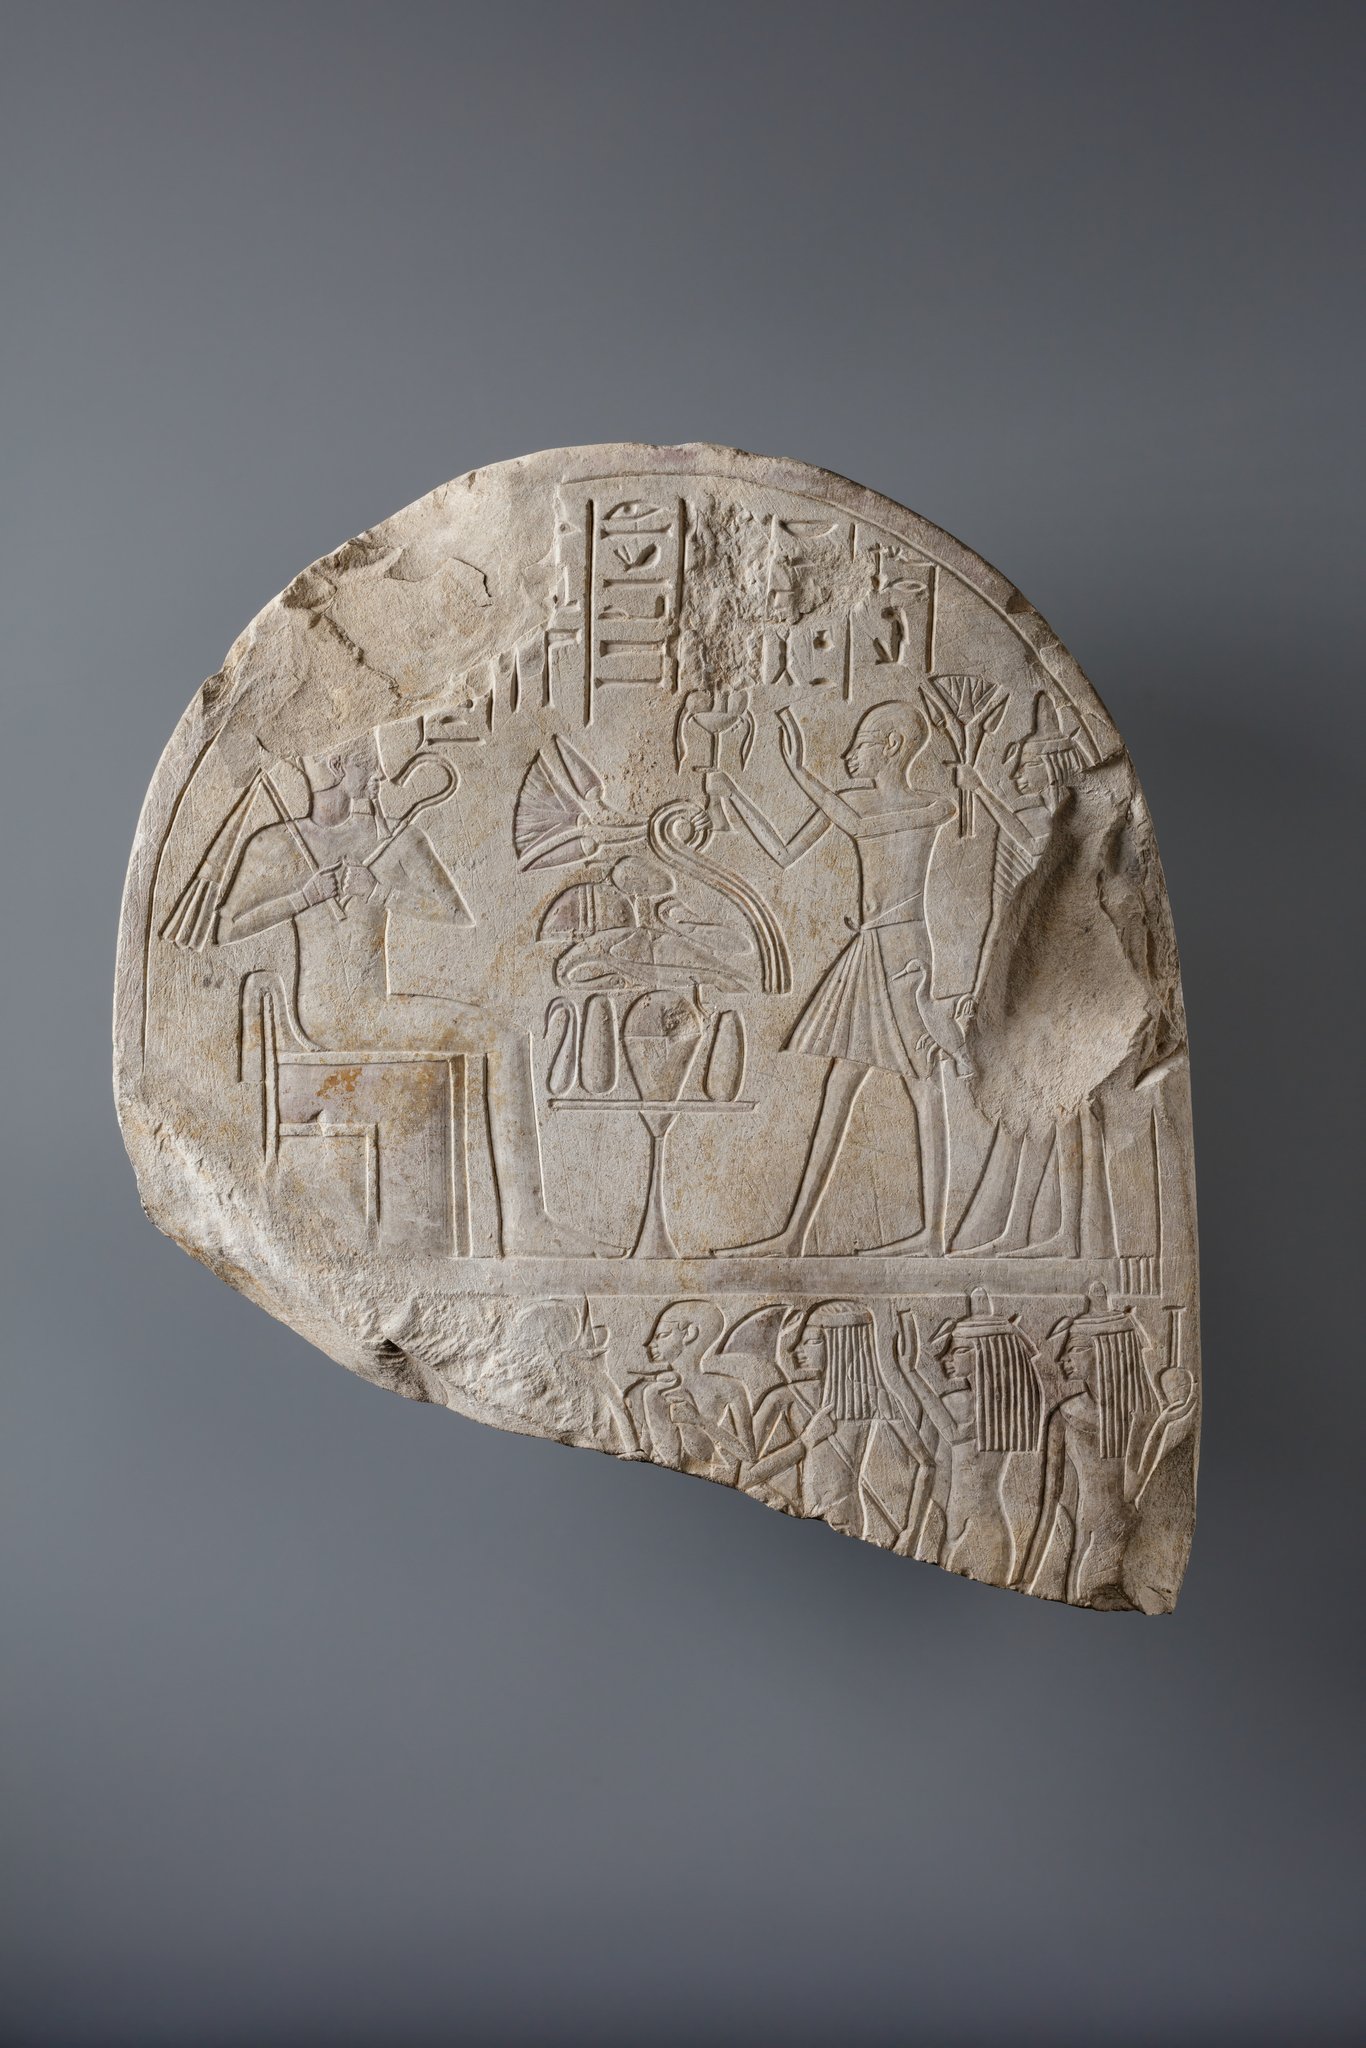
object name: stela, osiris, figure, henutnefret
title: Upper Portion of a Stela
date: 1390-1352 BCE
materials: limestone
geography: egypt